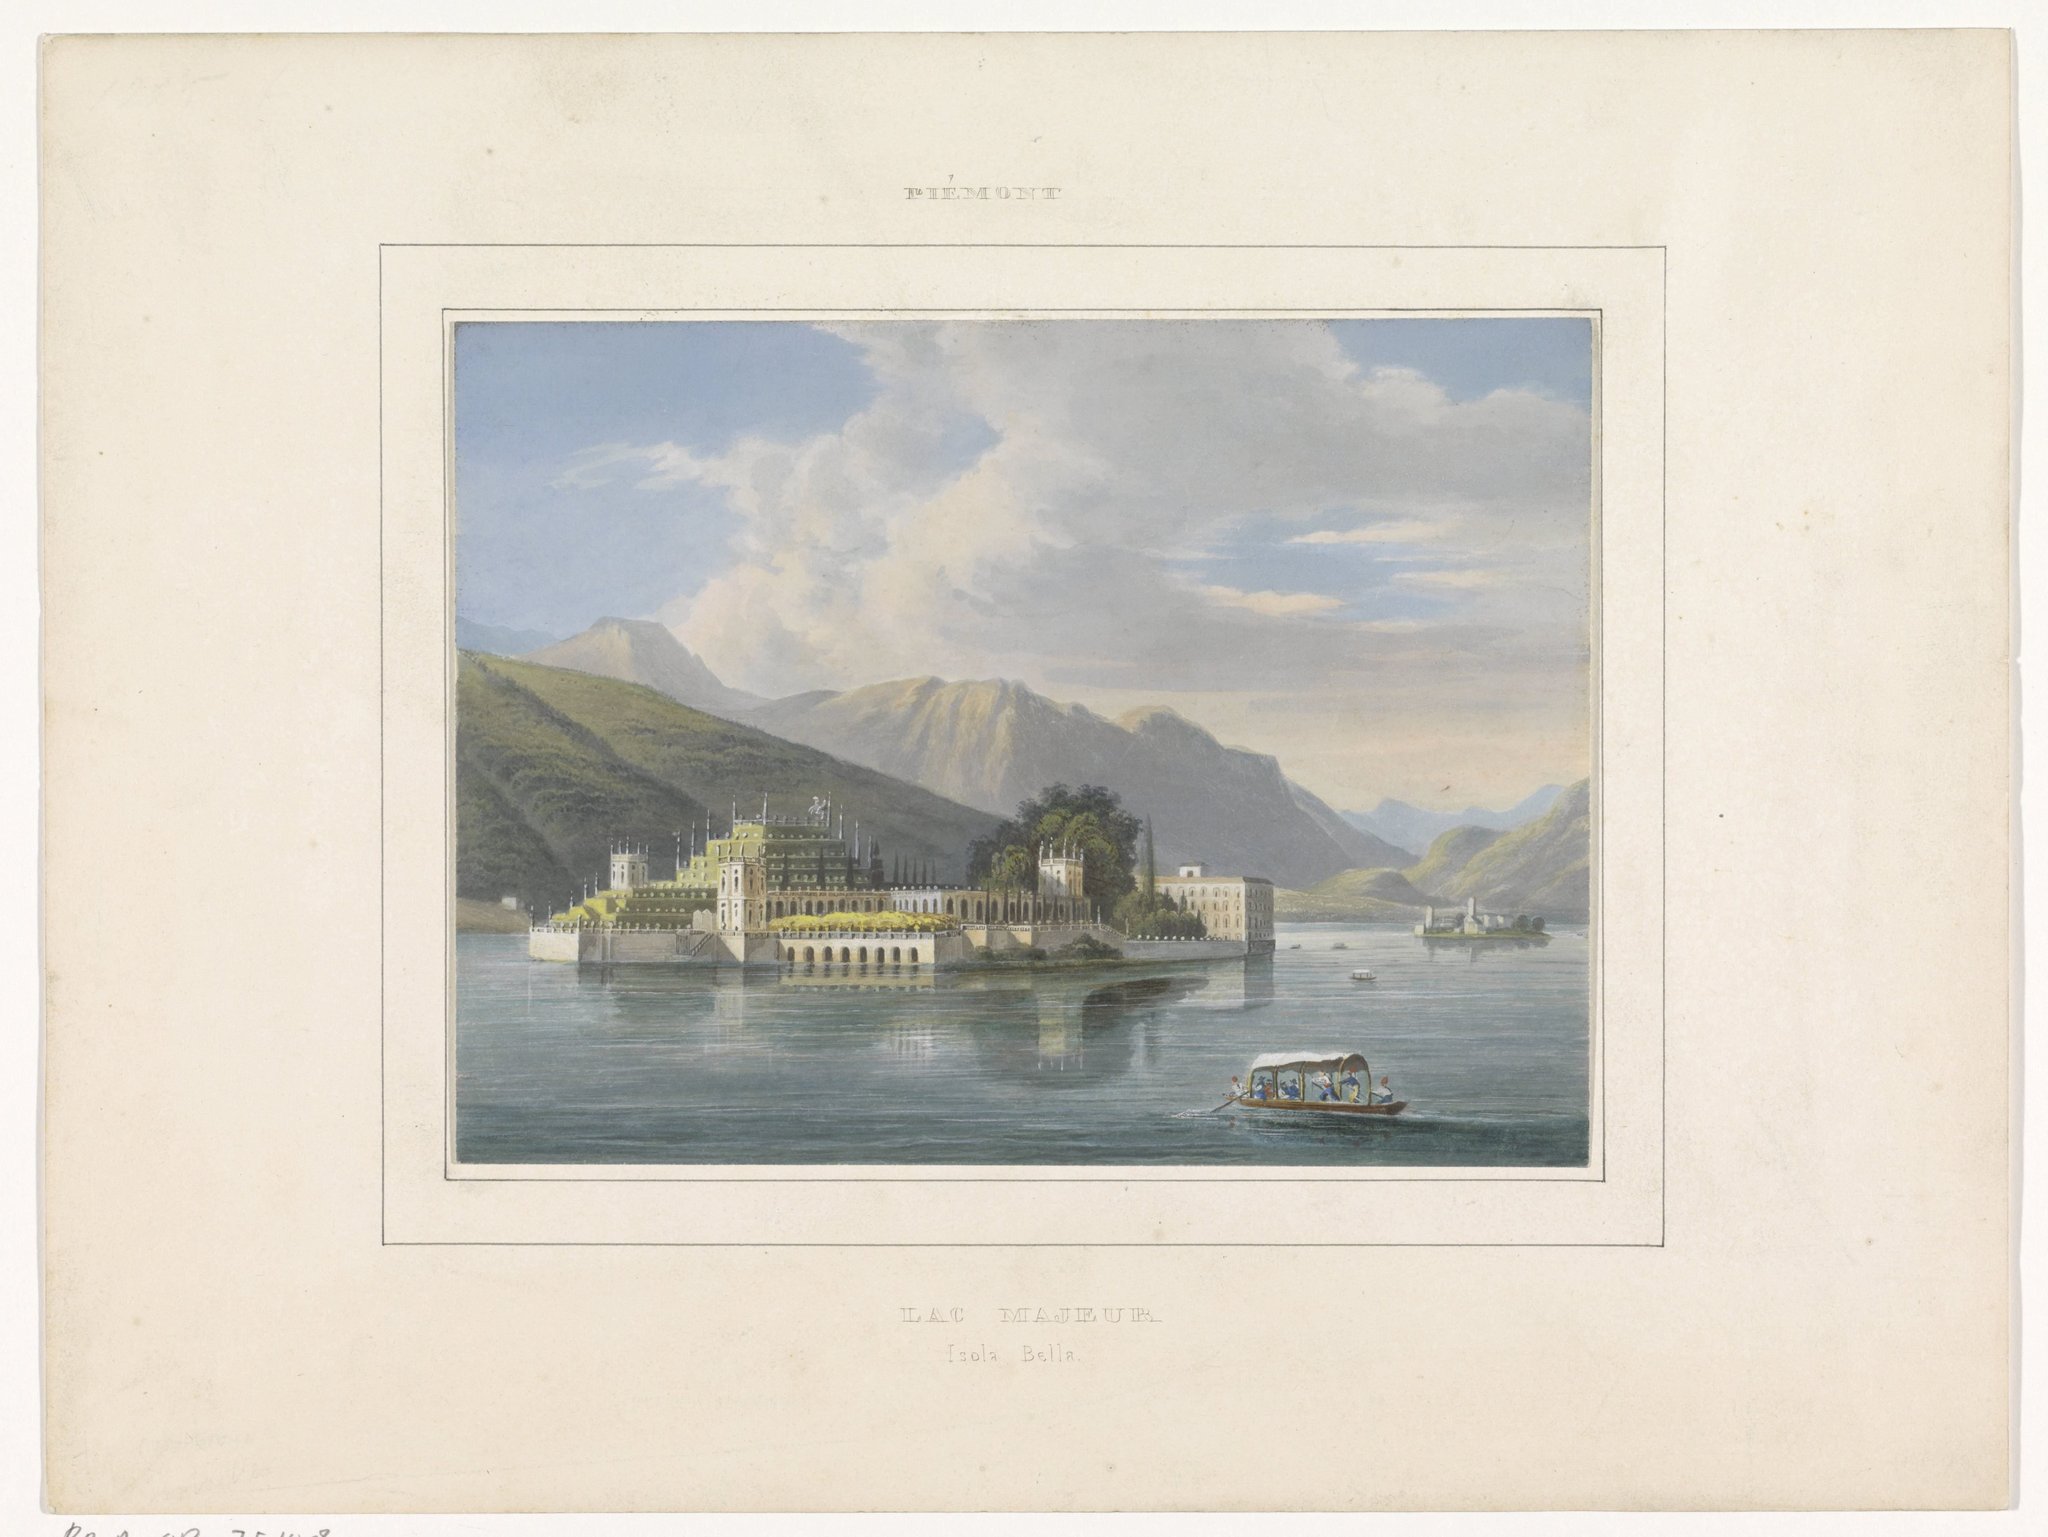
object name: print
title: Gezicht op Isola Bella, Lago Maggiore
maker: Anonymous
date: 1700-1900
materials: paper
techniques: aquatint, hand coloring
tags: island, castle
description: Gezicht op het eiland Isola Bella met paleis en tuinen.